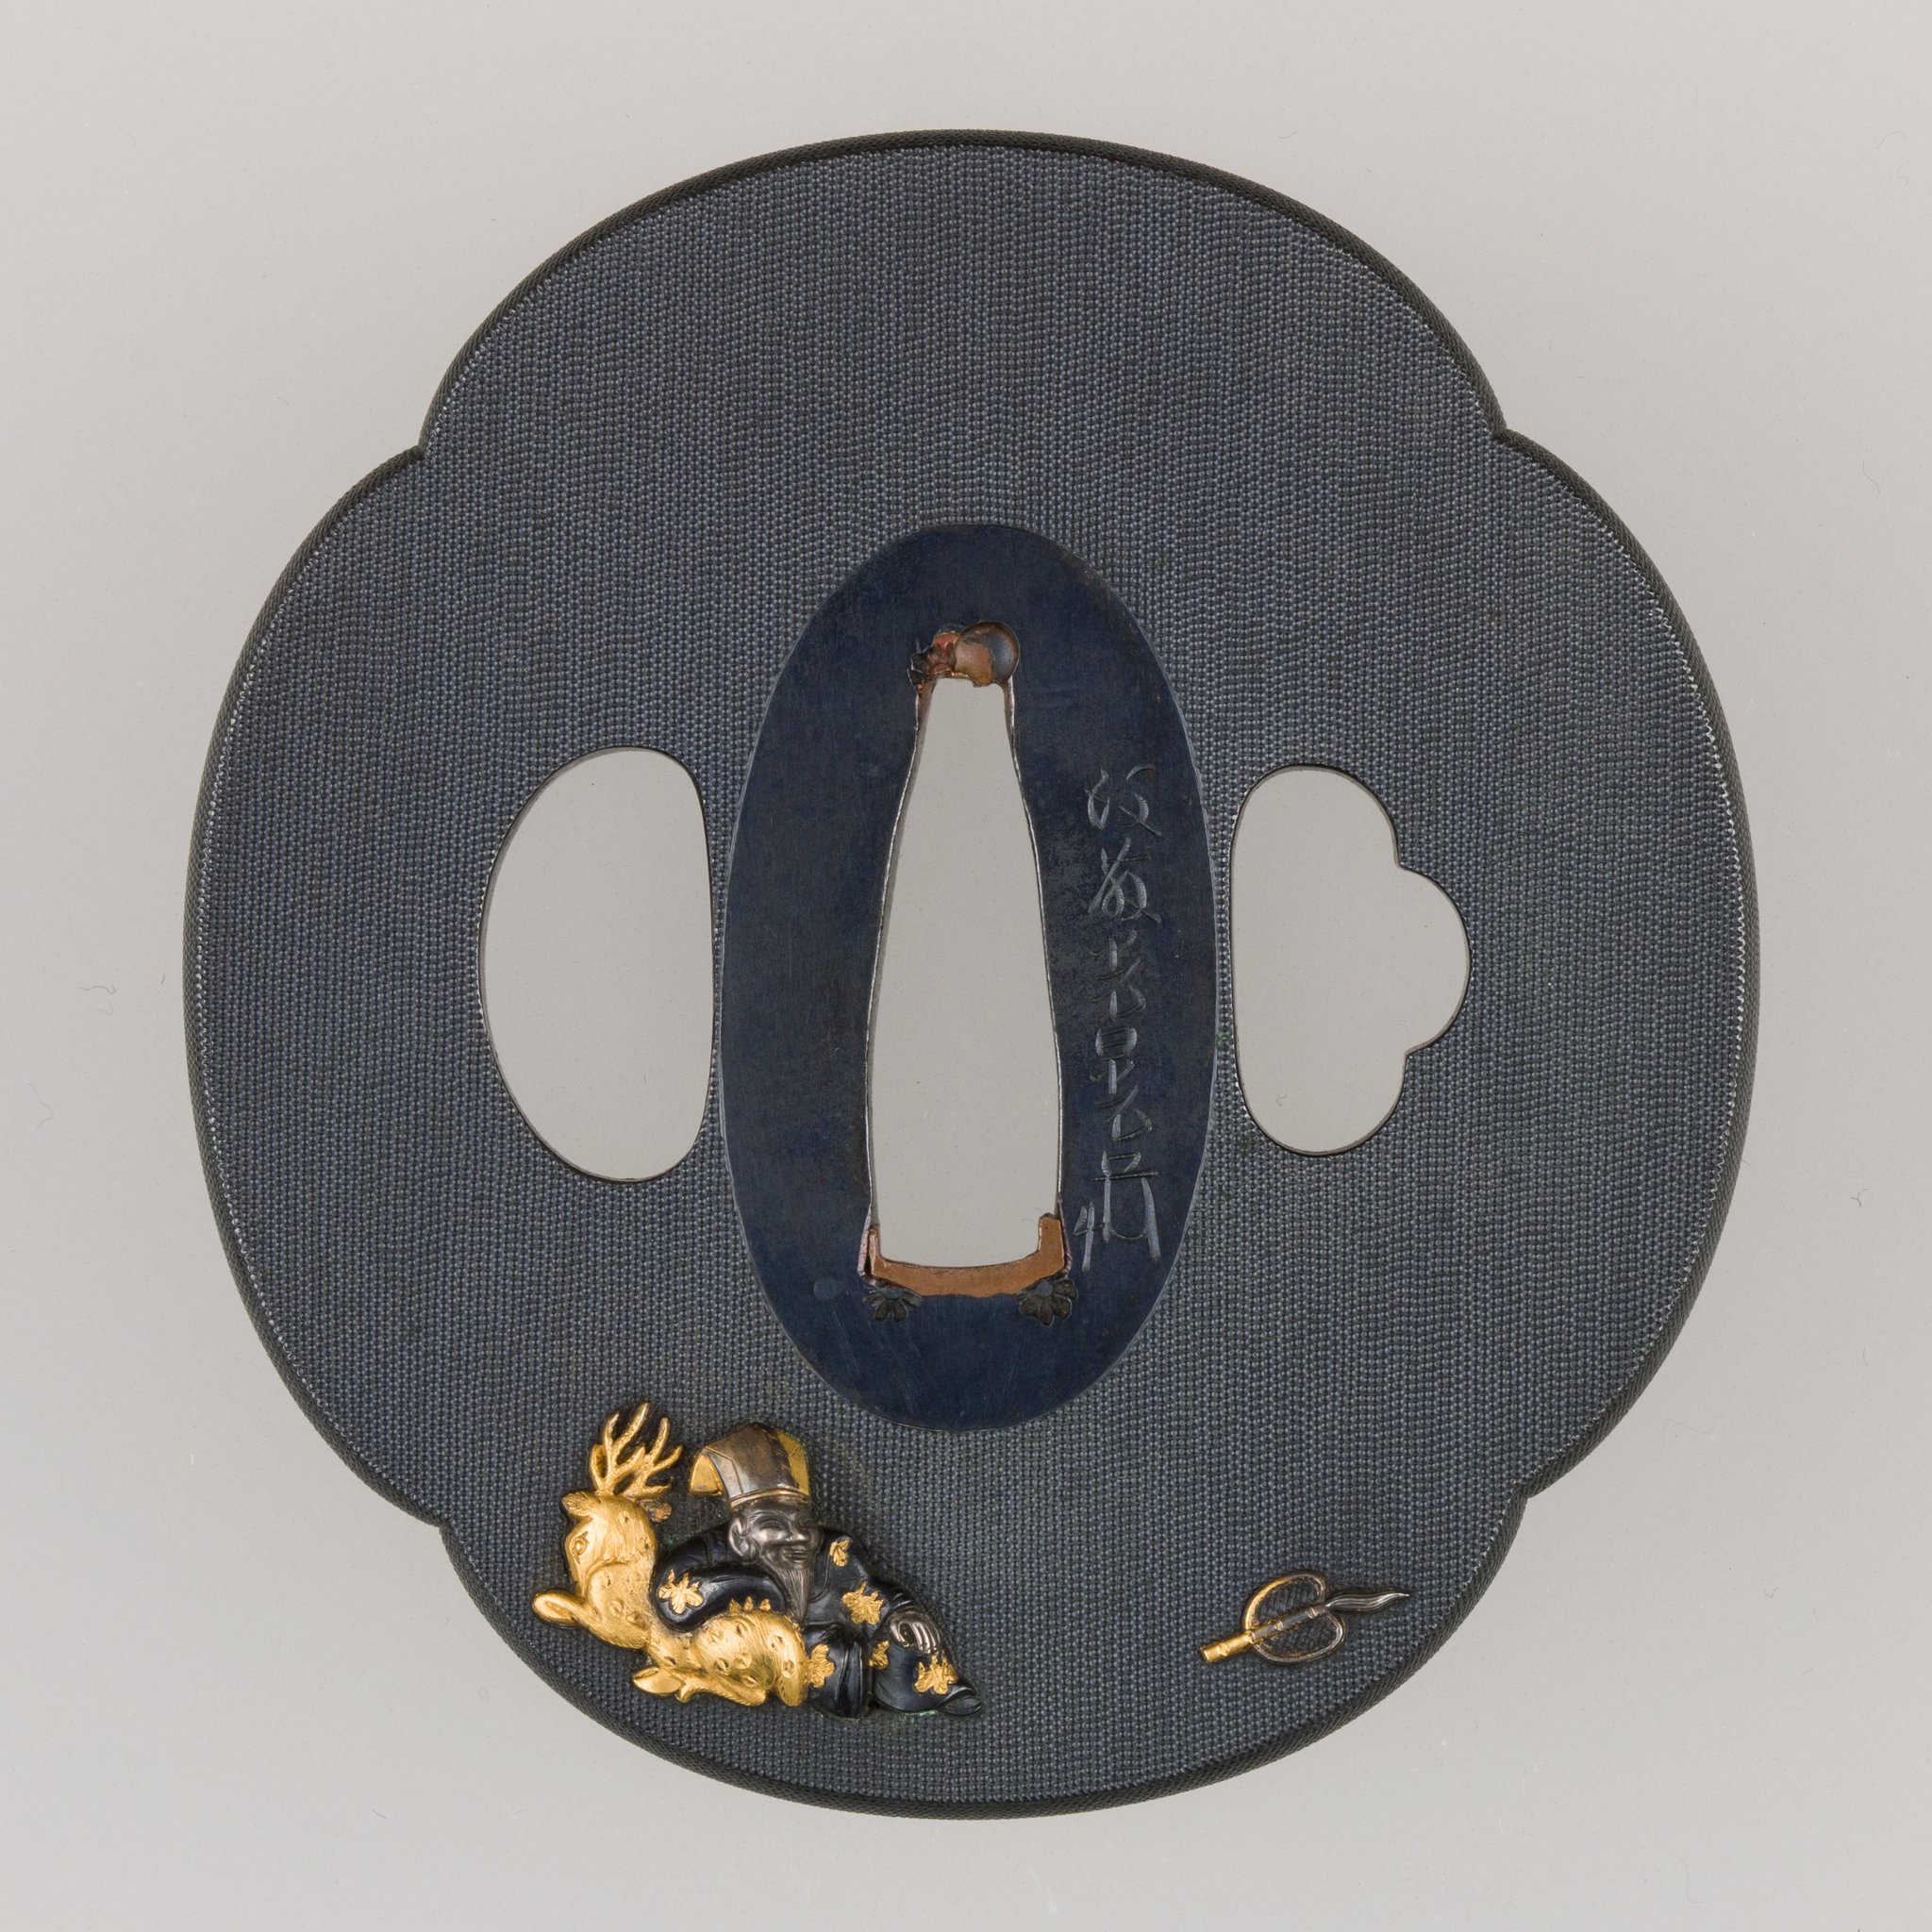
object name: sword guard tsuba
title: Sword Guard (Tsuba)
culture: japanese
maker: gotō mitsuakira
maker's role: fittings maker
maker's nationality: japanese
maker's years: 1816-1856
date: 1801-1900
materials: copper, gold alloy, gold, silver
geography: japan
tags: men,deer